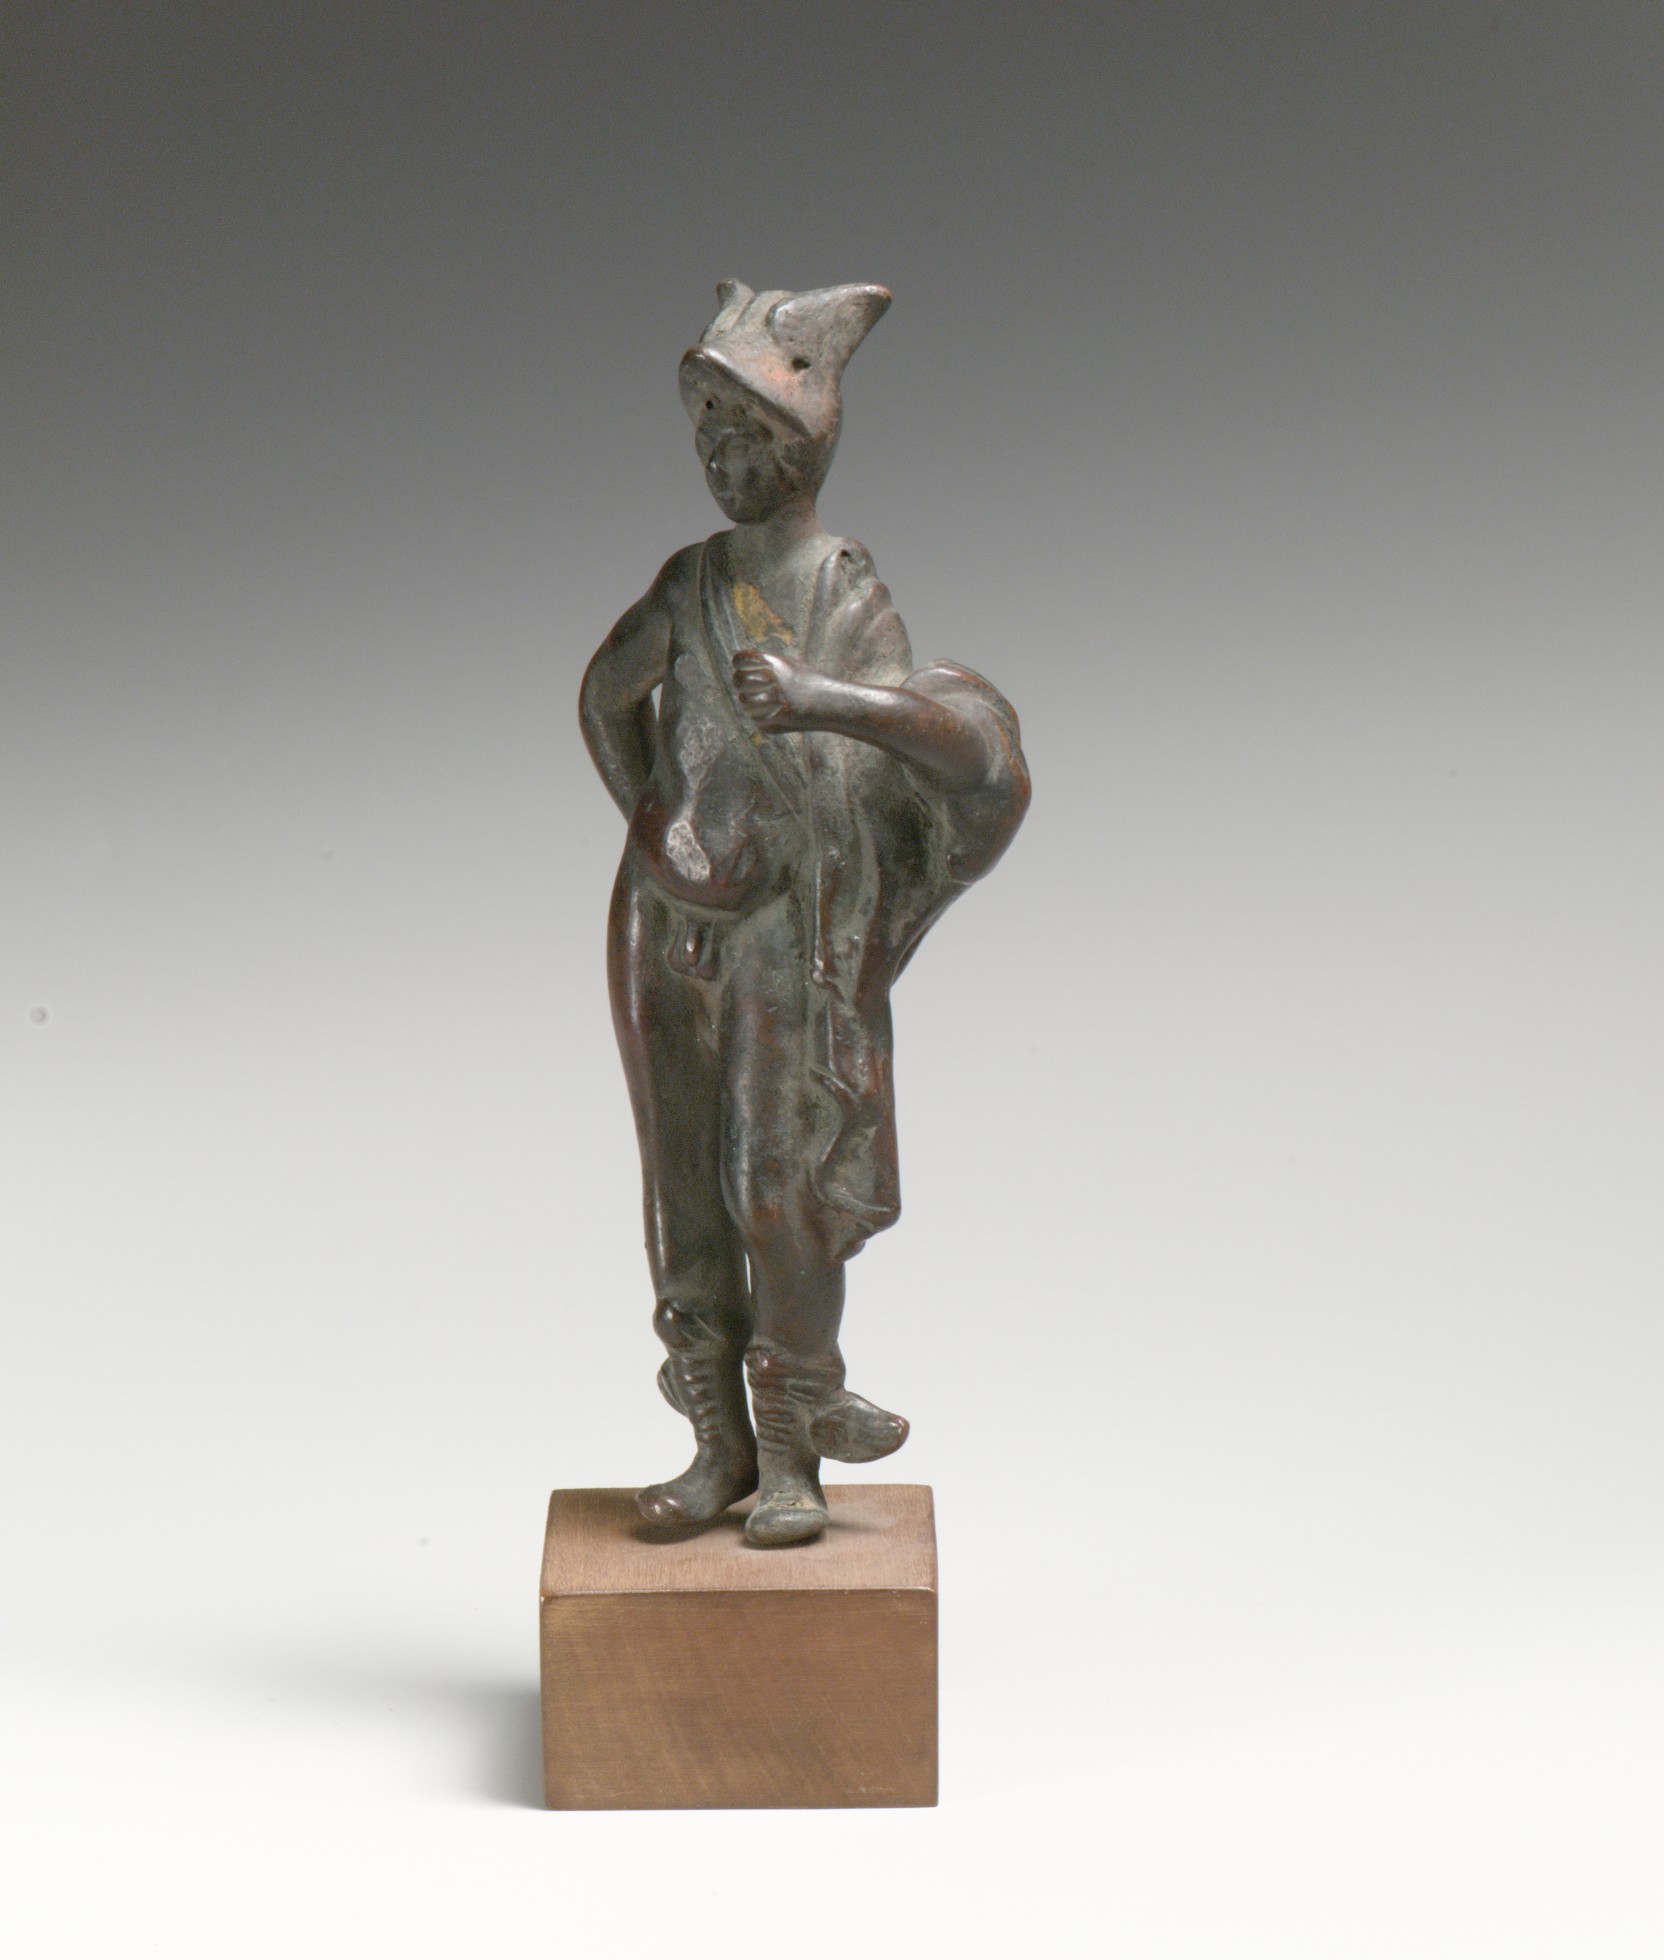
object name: statuette of hermes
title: Bronze statuette of Hermes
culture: greek or roman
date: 100 BCE-200 CE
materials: bronze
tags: hermes